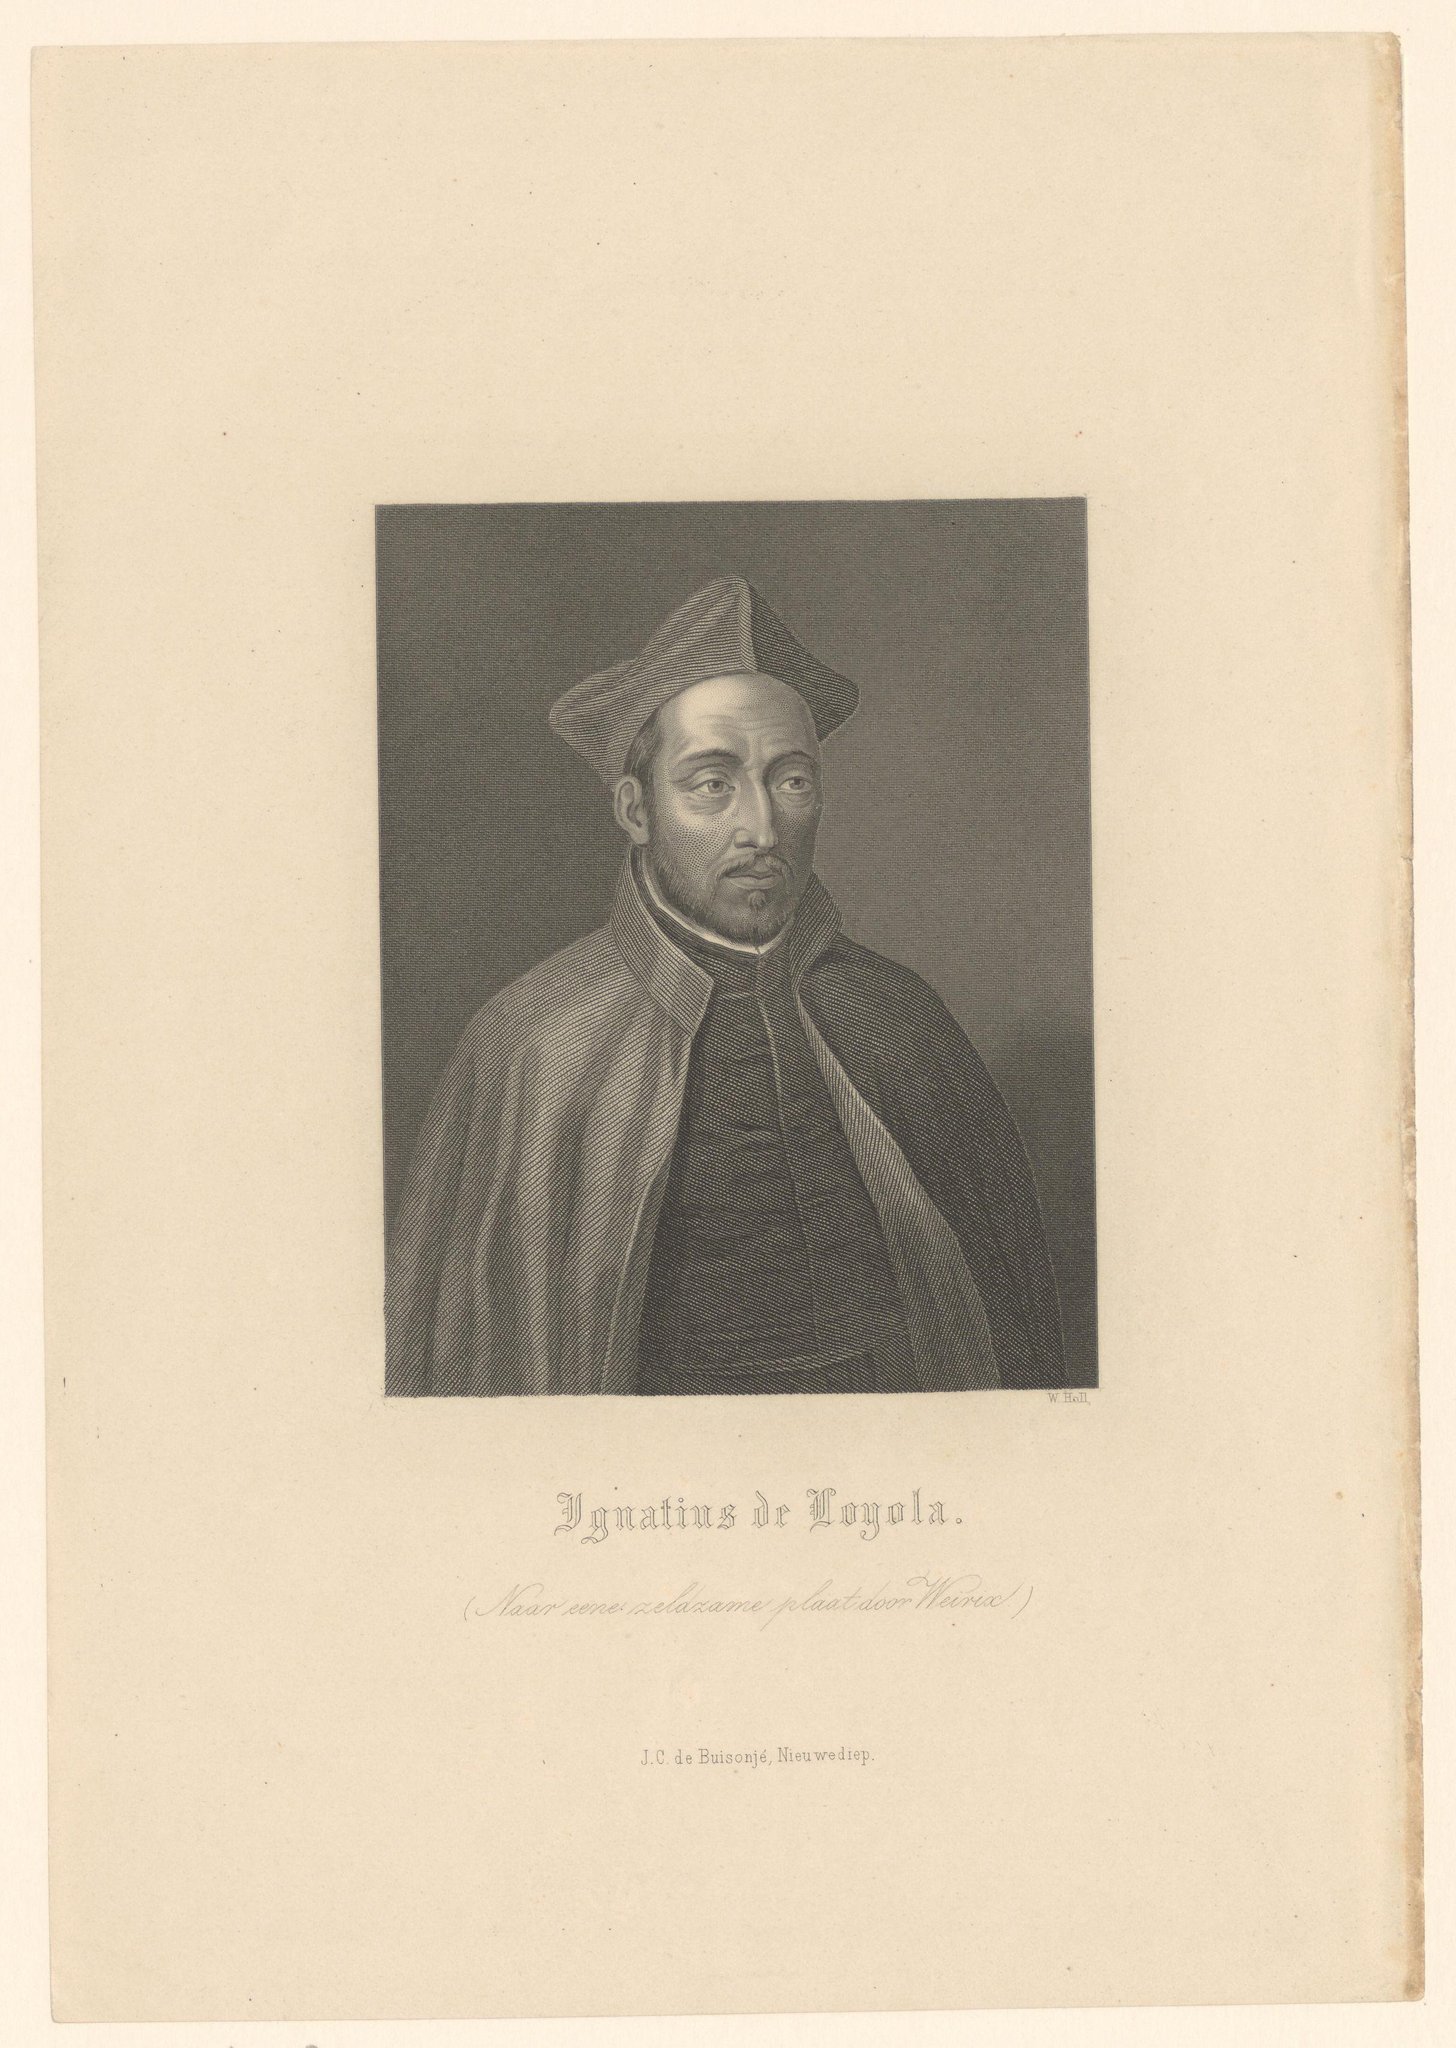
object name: print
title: Ignatius de Loyola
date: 1817-1871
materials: paper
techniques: etching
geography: nieuwediep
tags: historical persons, regular clerics, e.g. jesuits, redemptorists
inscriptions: collector's mark: Lugt 2228